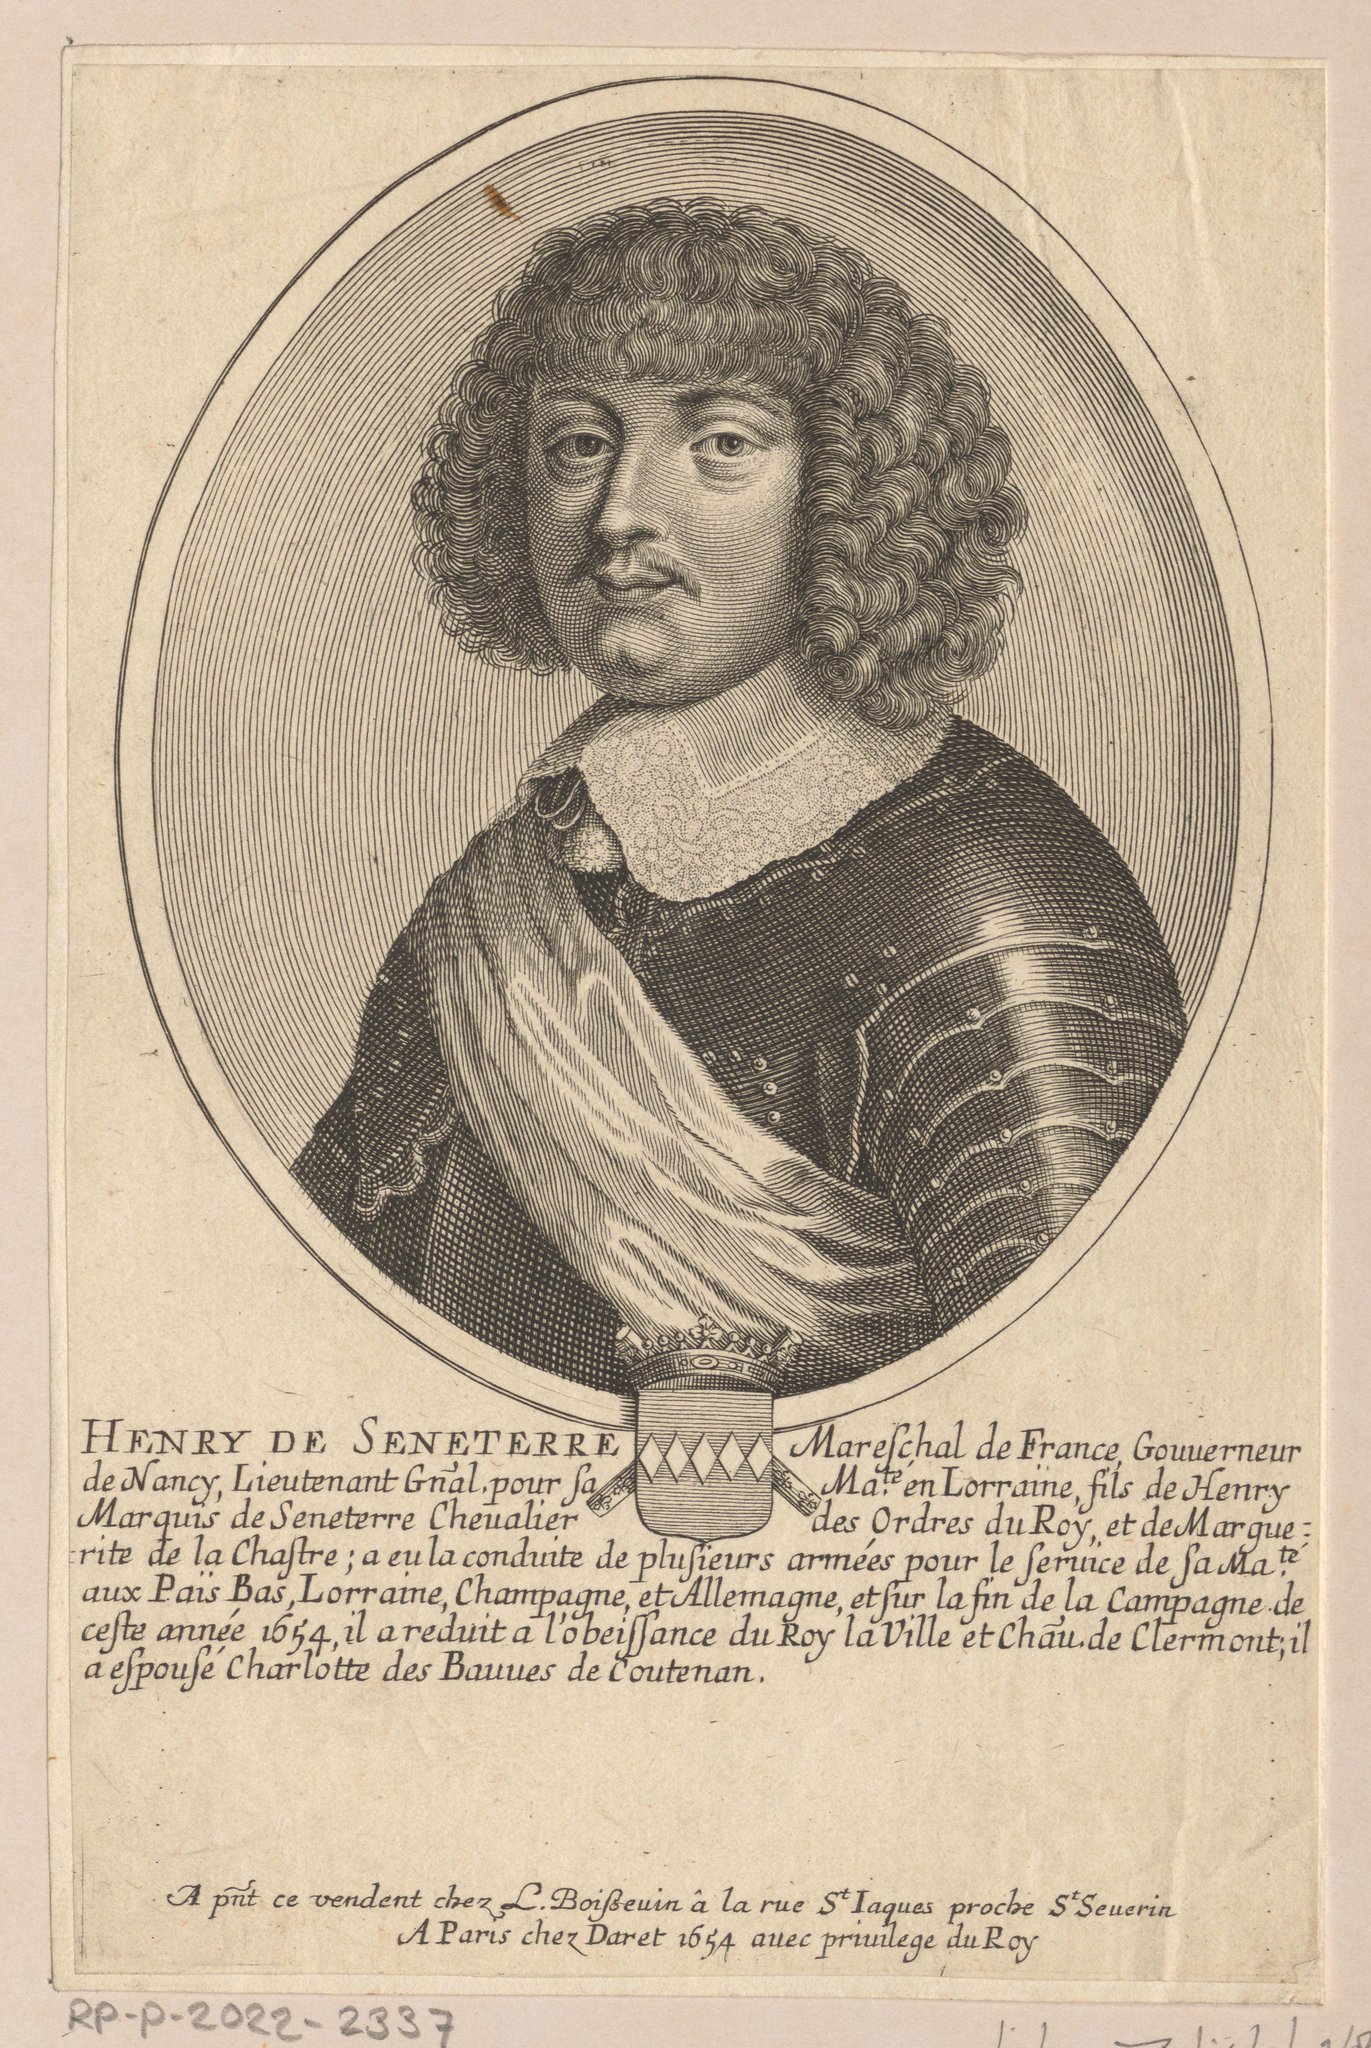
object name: print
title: Portret van Henri de la Ferté-Senneterre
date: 1654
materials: paper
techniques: engraving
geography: france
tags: politician, commander-in-chief, general, marshal, historical persons, armorial bearing, heraldry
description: Met zevenregelig onderschrift in het Frans.